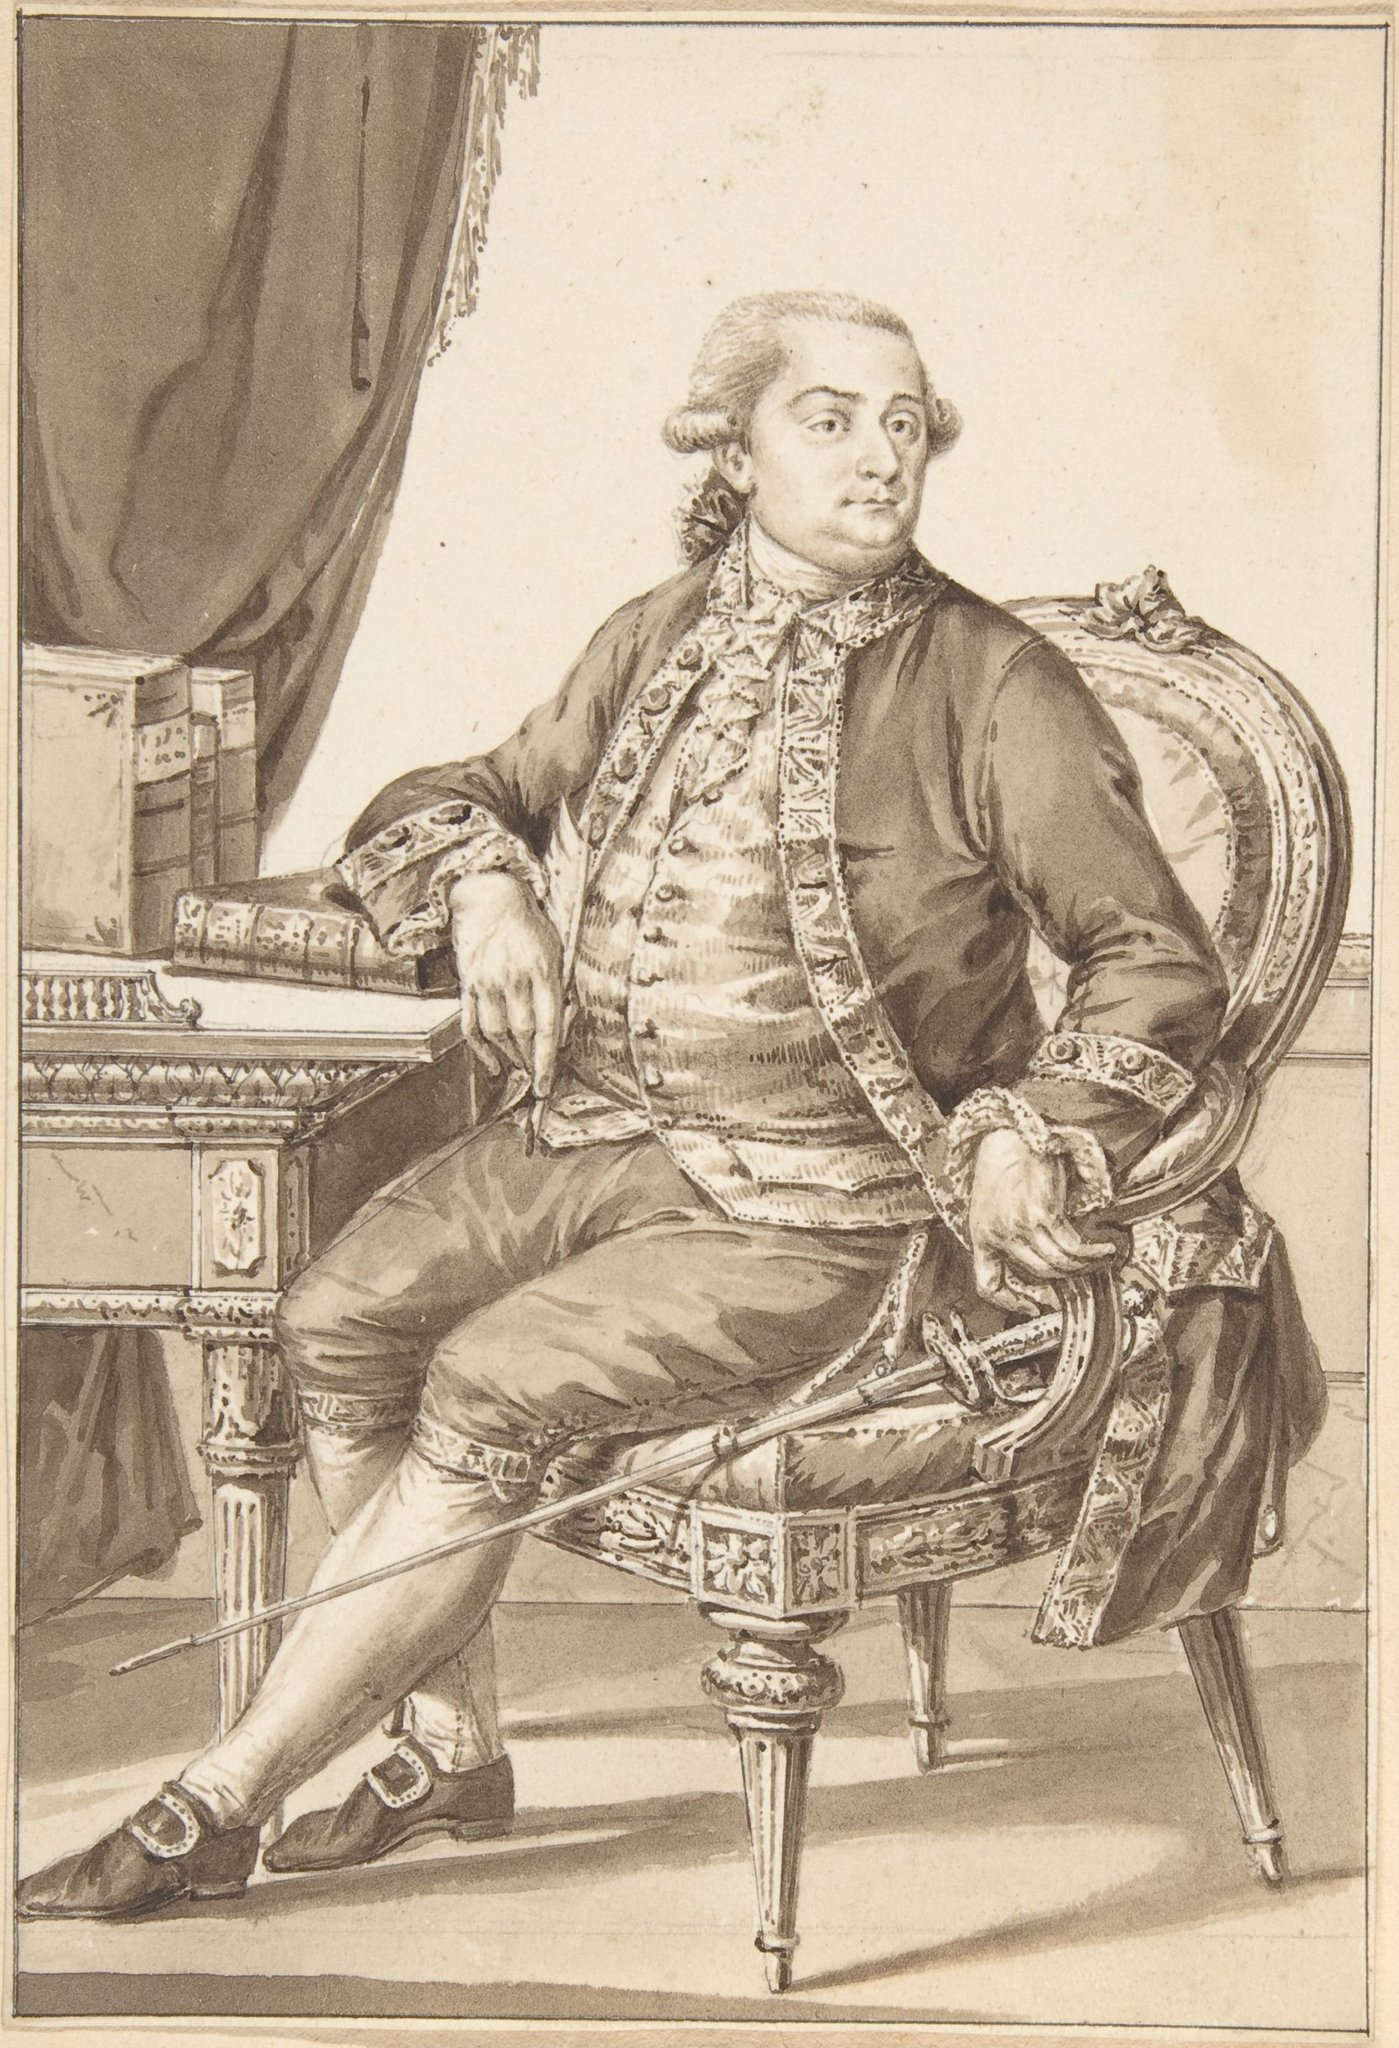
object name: drawing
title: Portrait of Cesare Bonesana, Marchese di Beccaria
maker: jean-baptiste-françois bosio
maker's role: artist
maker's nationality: french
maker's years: 1764-1827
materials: graphite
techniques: brush, wash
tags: men,portraits